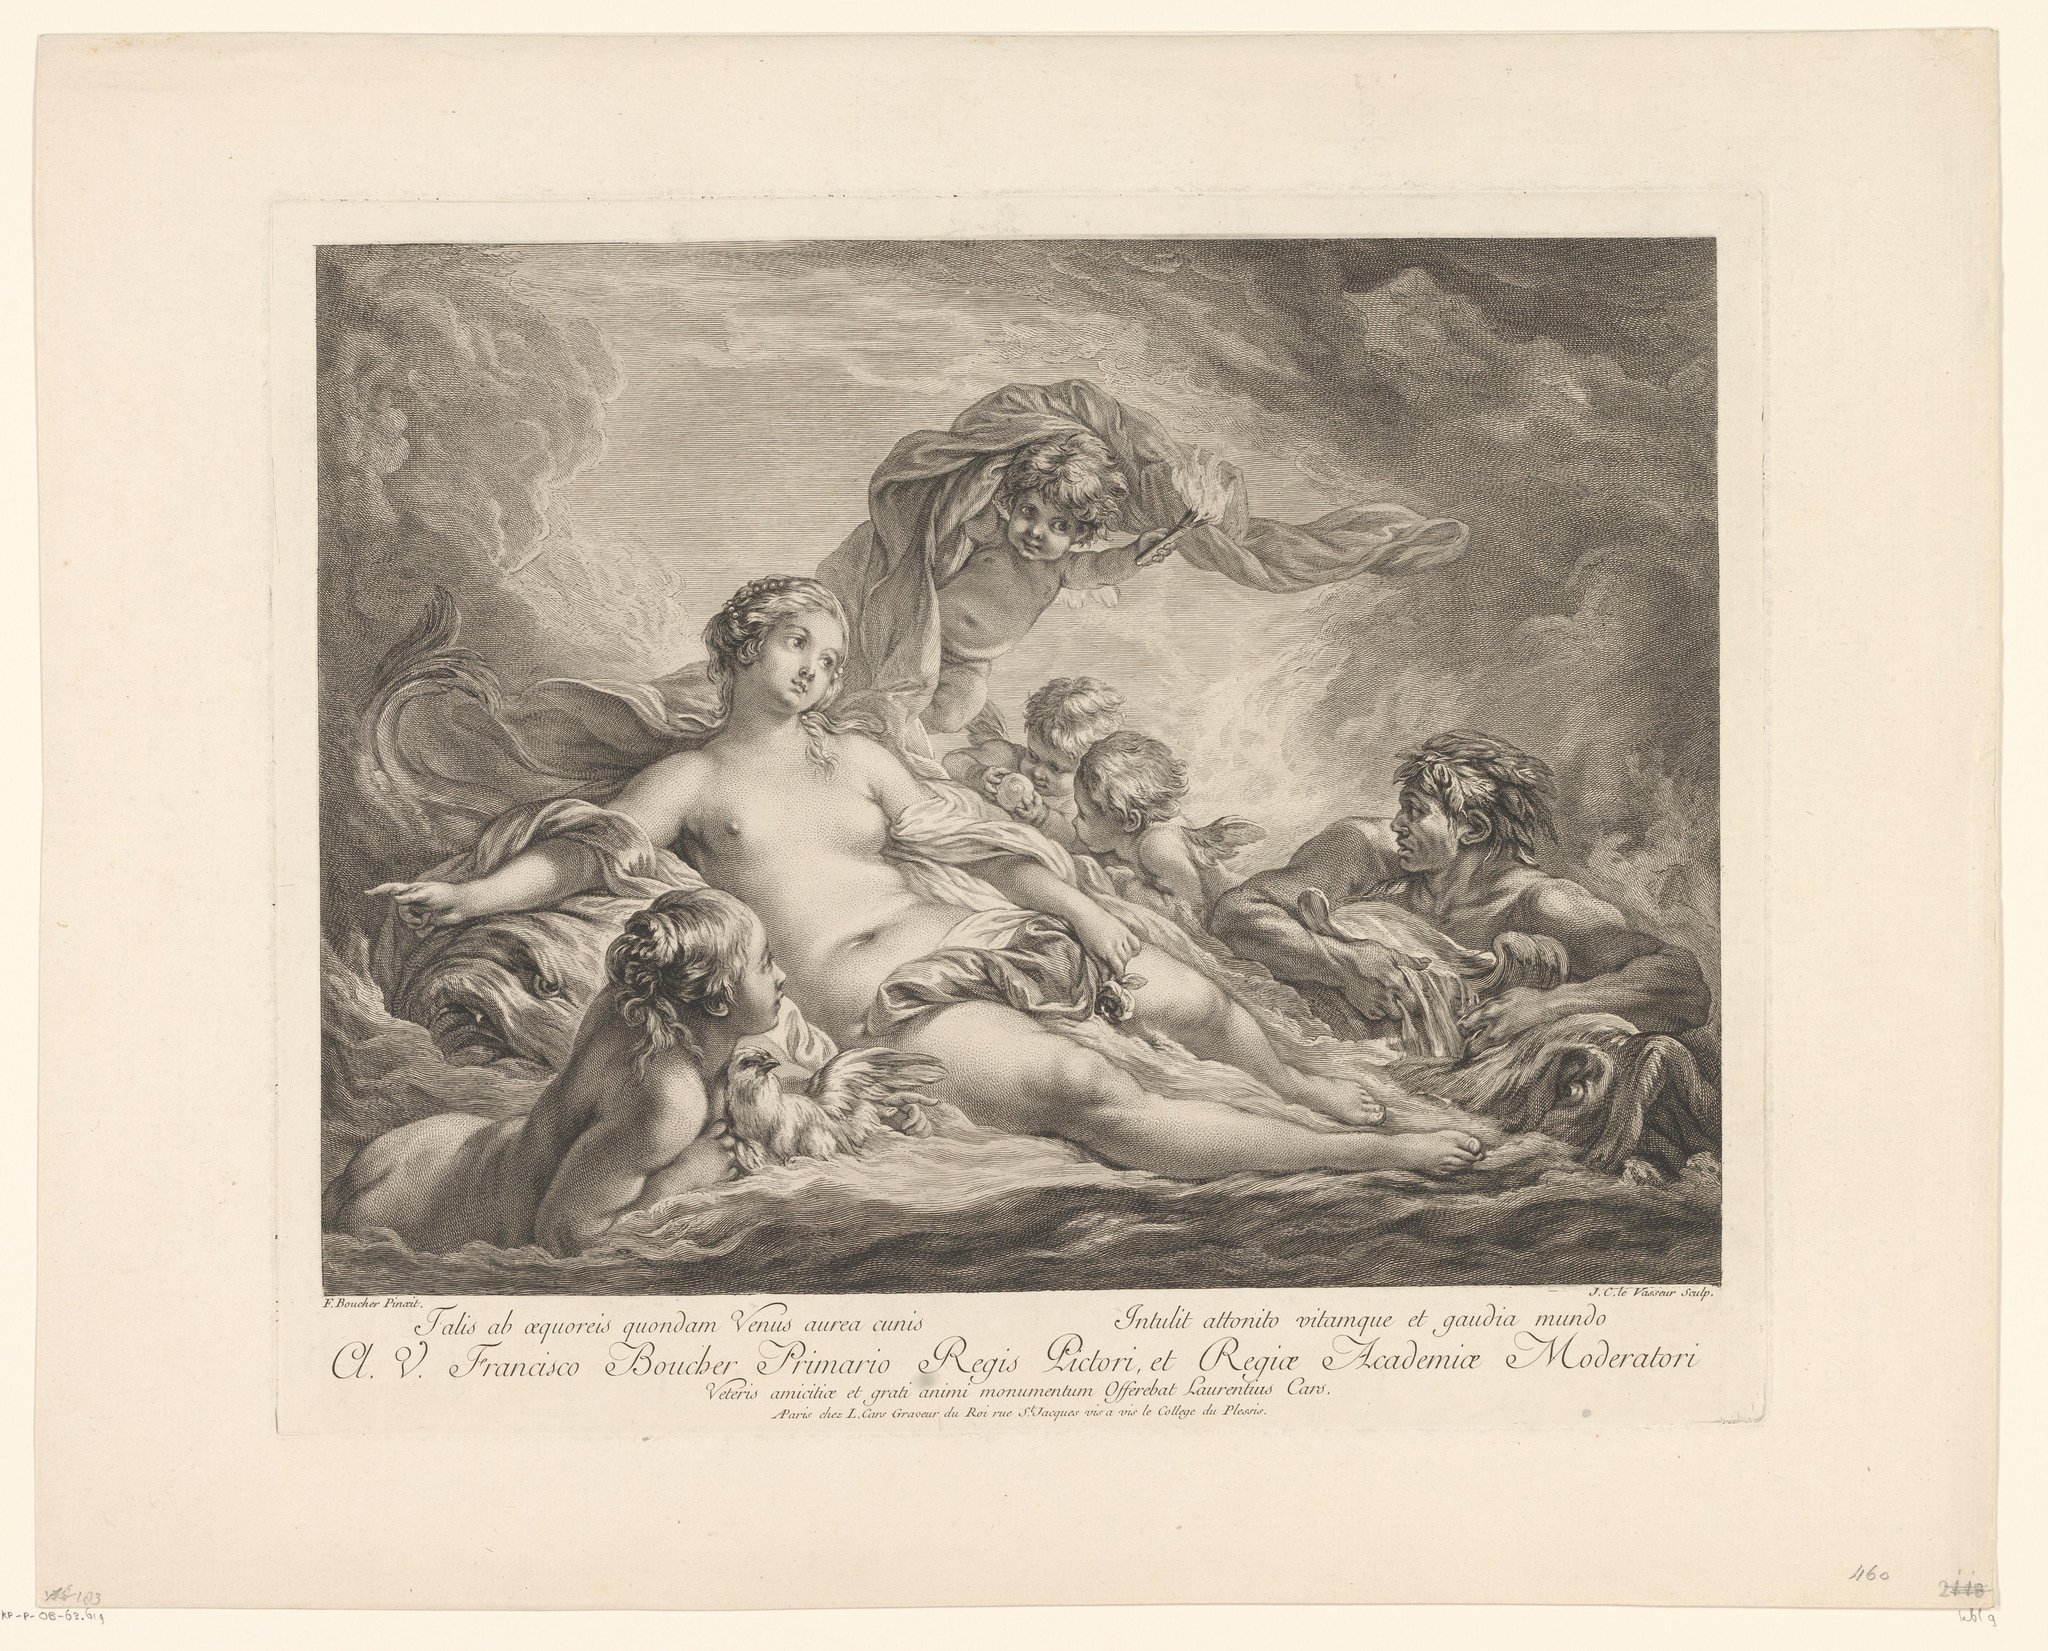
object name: print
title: Geboorte van Venus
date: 1744-1771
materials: paper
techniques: engraving, etching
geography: paris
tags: birth of venus; venus anadyomene: after uranus' castration venus rises from the sea wringing the water from her hair; usually she is awaited by the hours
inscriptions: collector's mark: Lugt 240